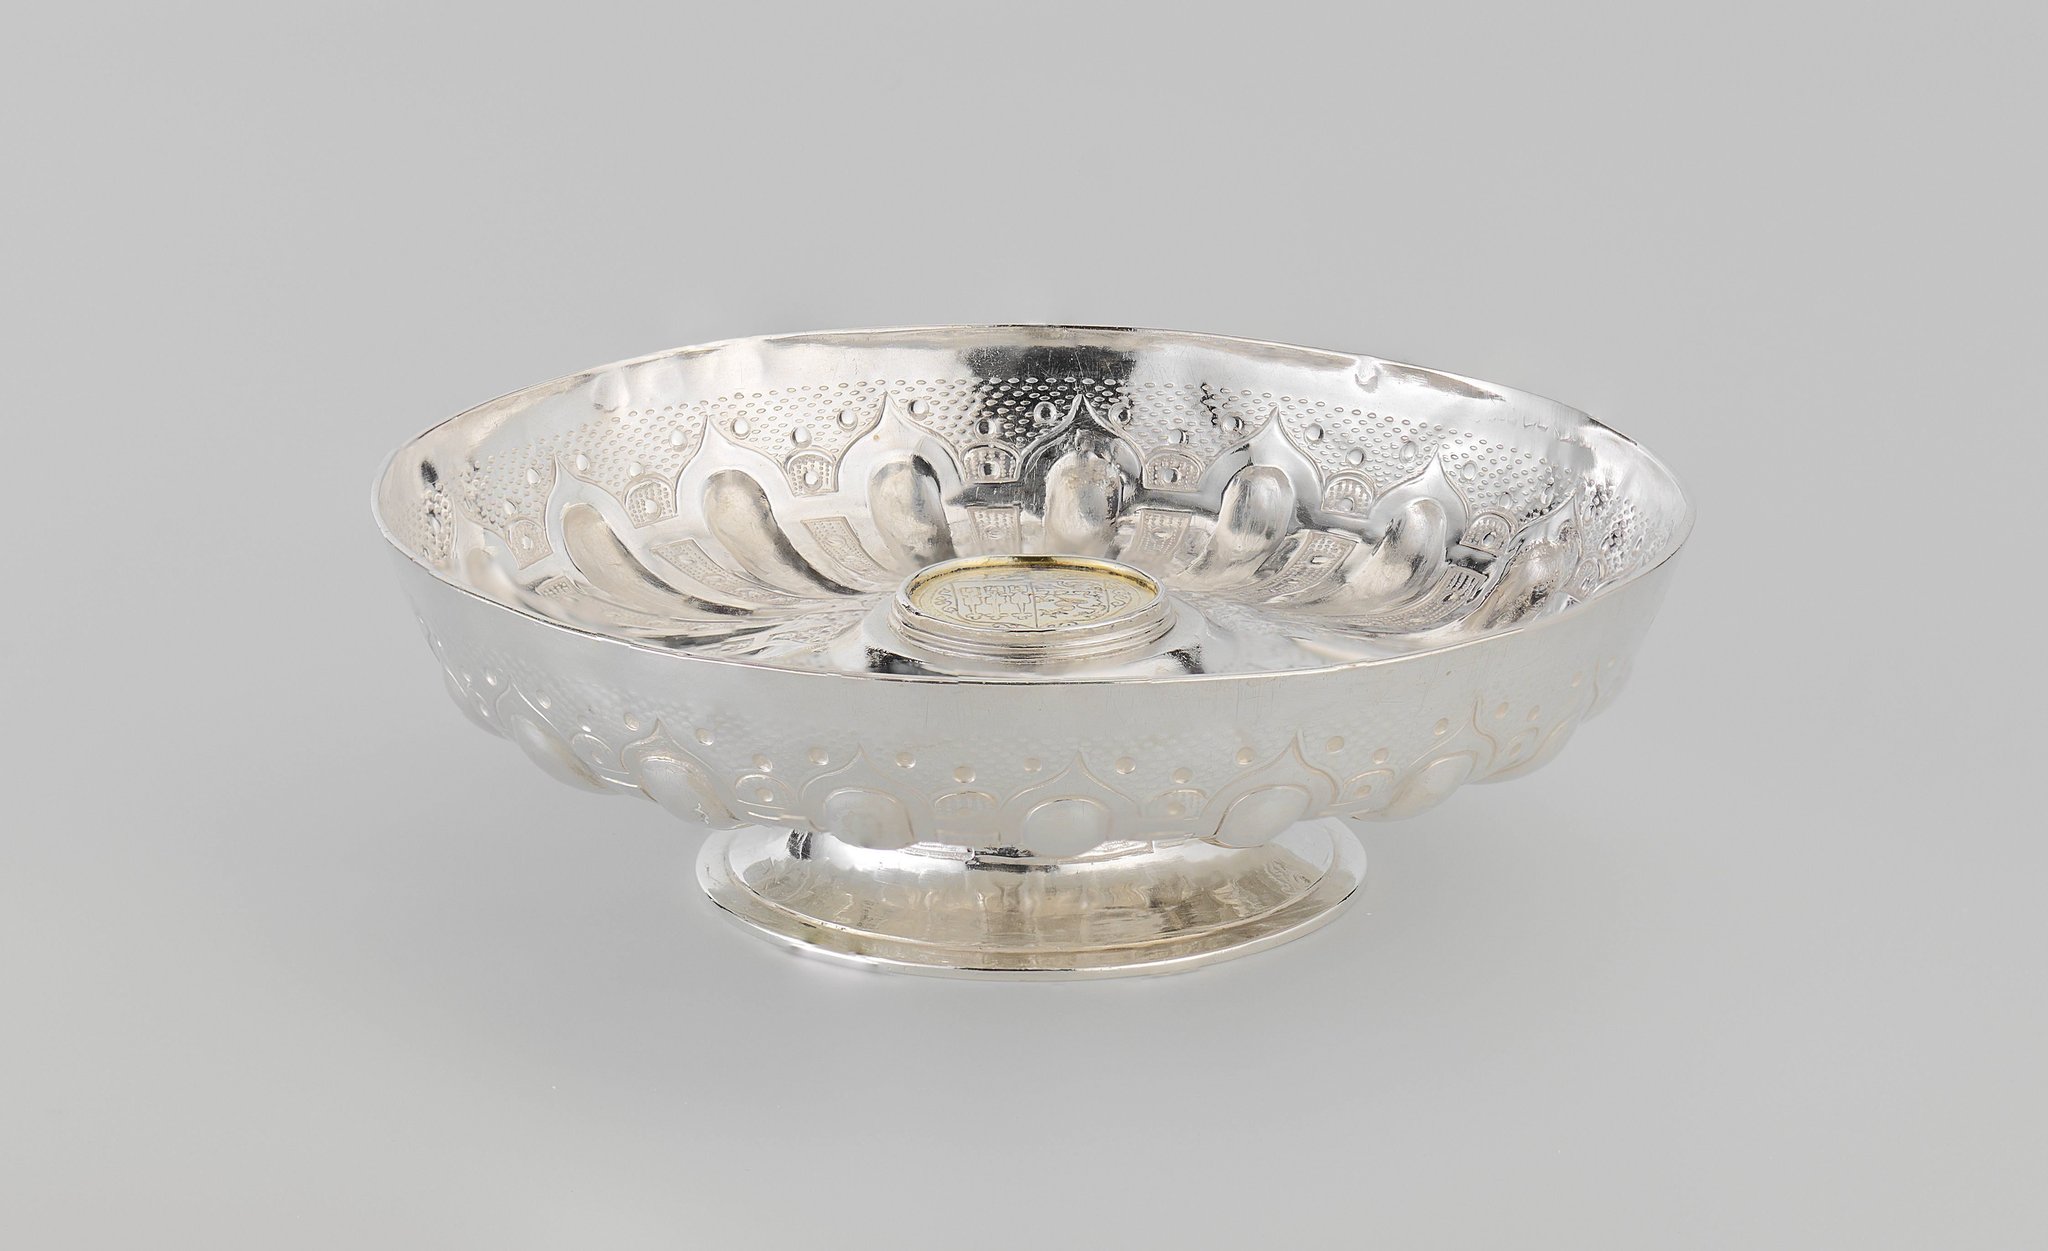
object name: tazza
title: Drinkschaal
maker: Anonymous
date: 1568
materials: silver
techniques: gilding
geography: leiden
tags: ornaments ~ art, leiden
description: Drinkschaal op voet. Gedeeltelijk verguld zilver. Leiden, 1568. Meester onbekend.